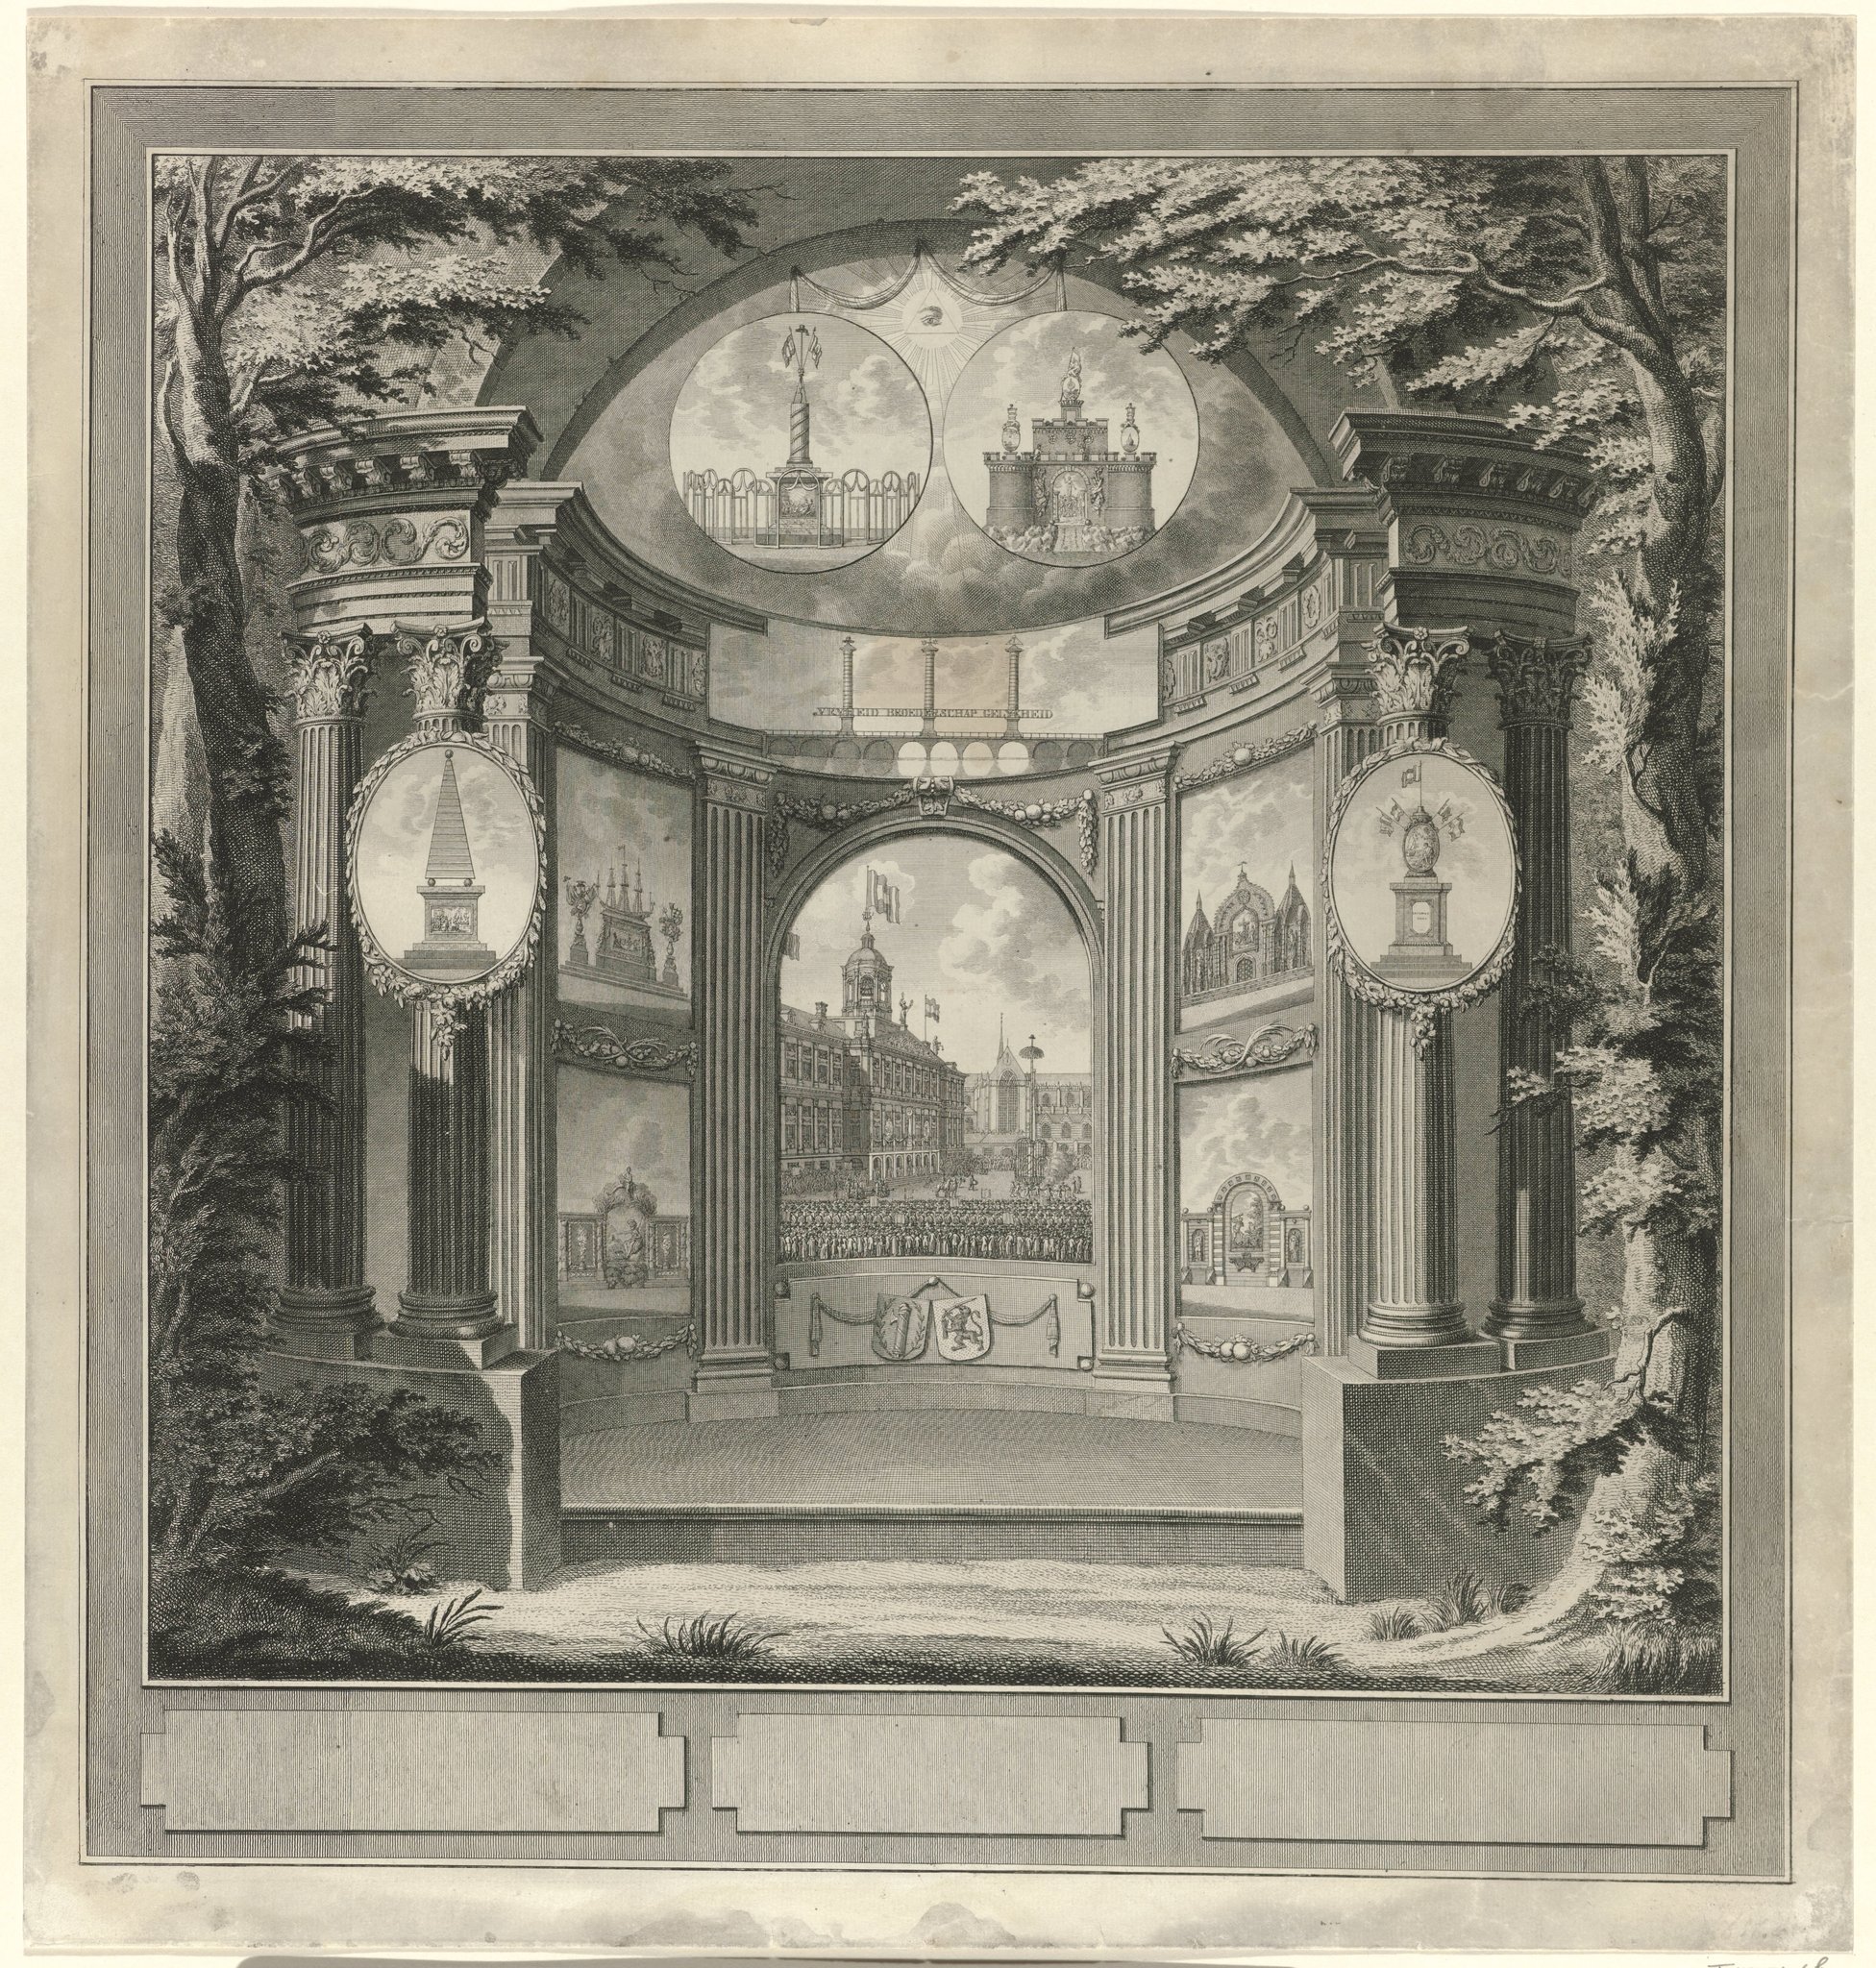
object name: print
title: Monument voor het Alliantiefeest te Amsterdam, 1795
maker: noach van der meer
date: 1795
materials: paper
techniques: engraving, etching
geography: netherlands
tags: festivities on events of national importance (+ festive decoration ~ festive activities), alliance with france (1795)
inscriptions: collector's mark: Lugt 2228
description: Monument in de vorm van een tempel waarin zijn afgebeeld alle decoraties opgericht bij het Alliantiefeest te Amsterdam op 19 juni 1795. Centraal een gezicht op het volksfeest gevierd op de Dam voor het Stadhuis.